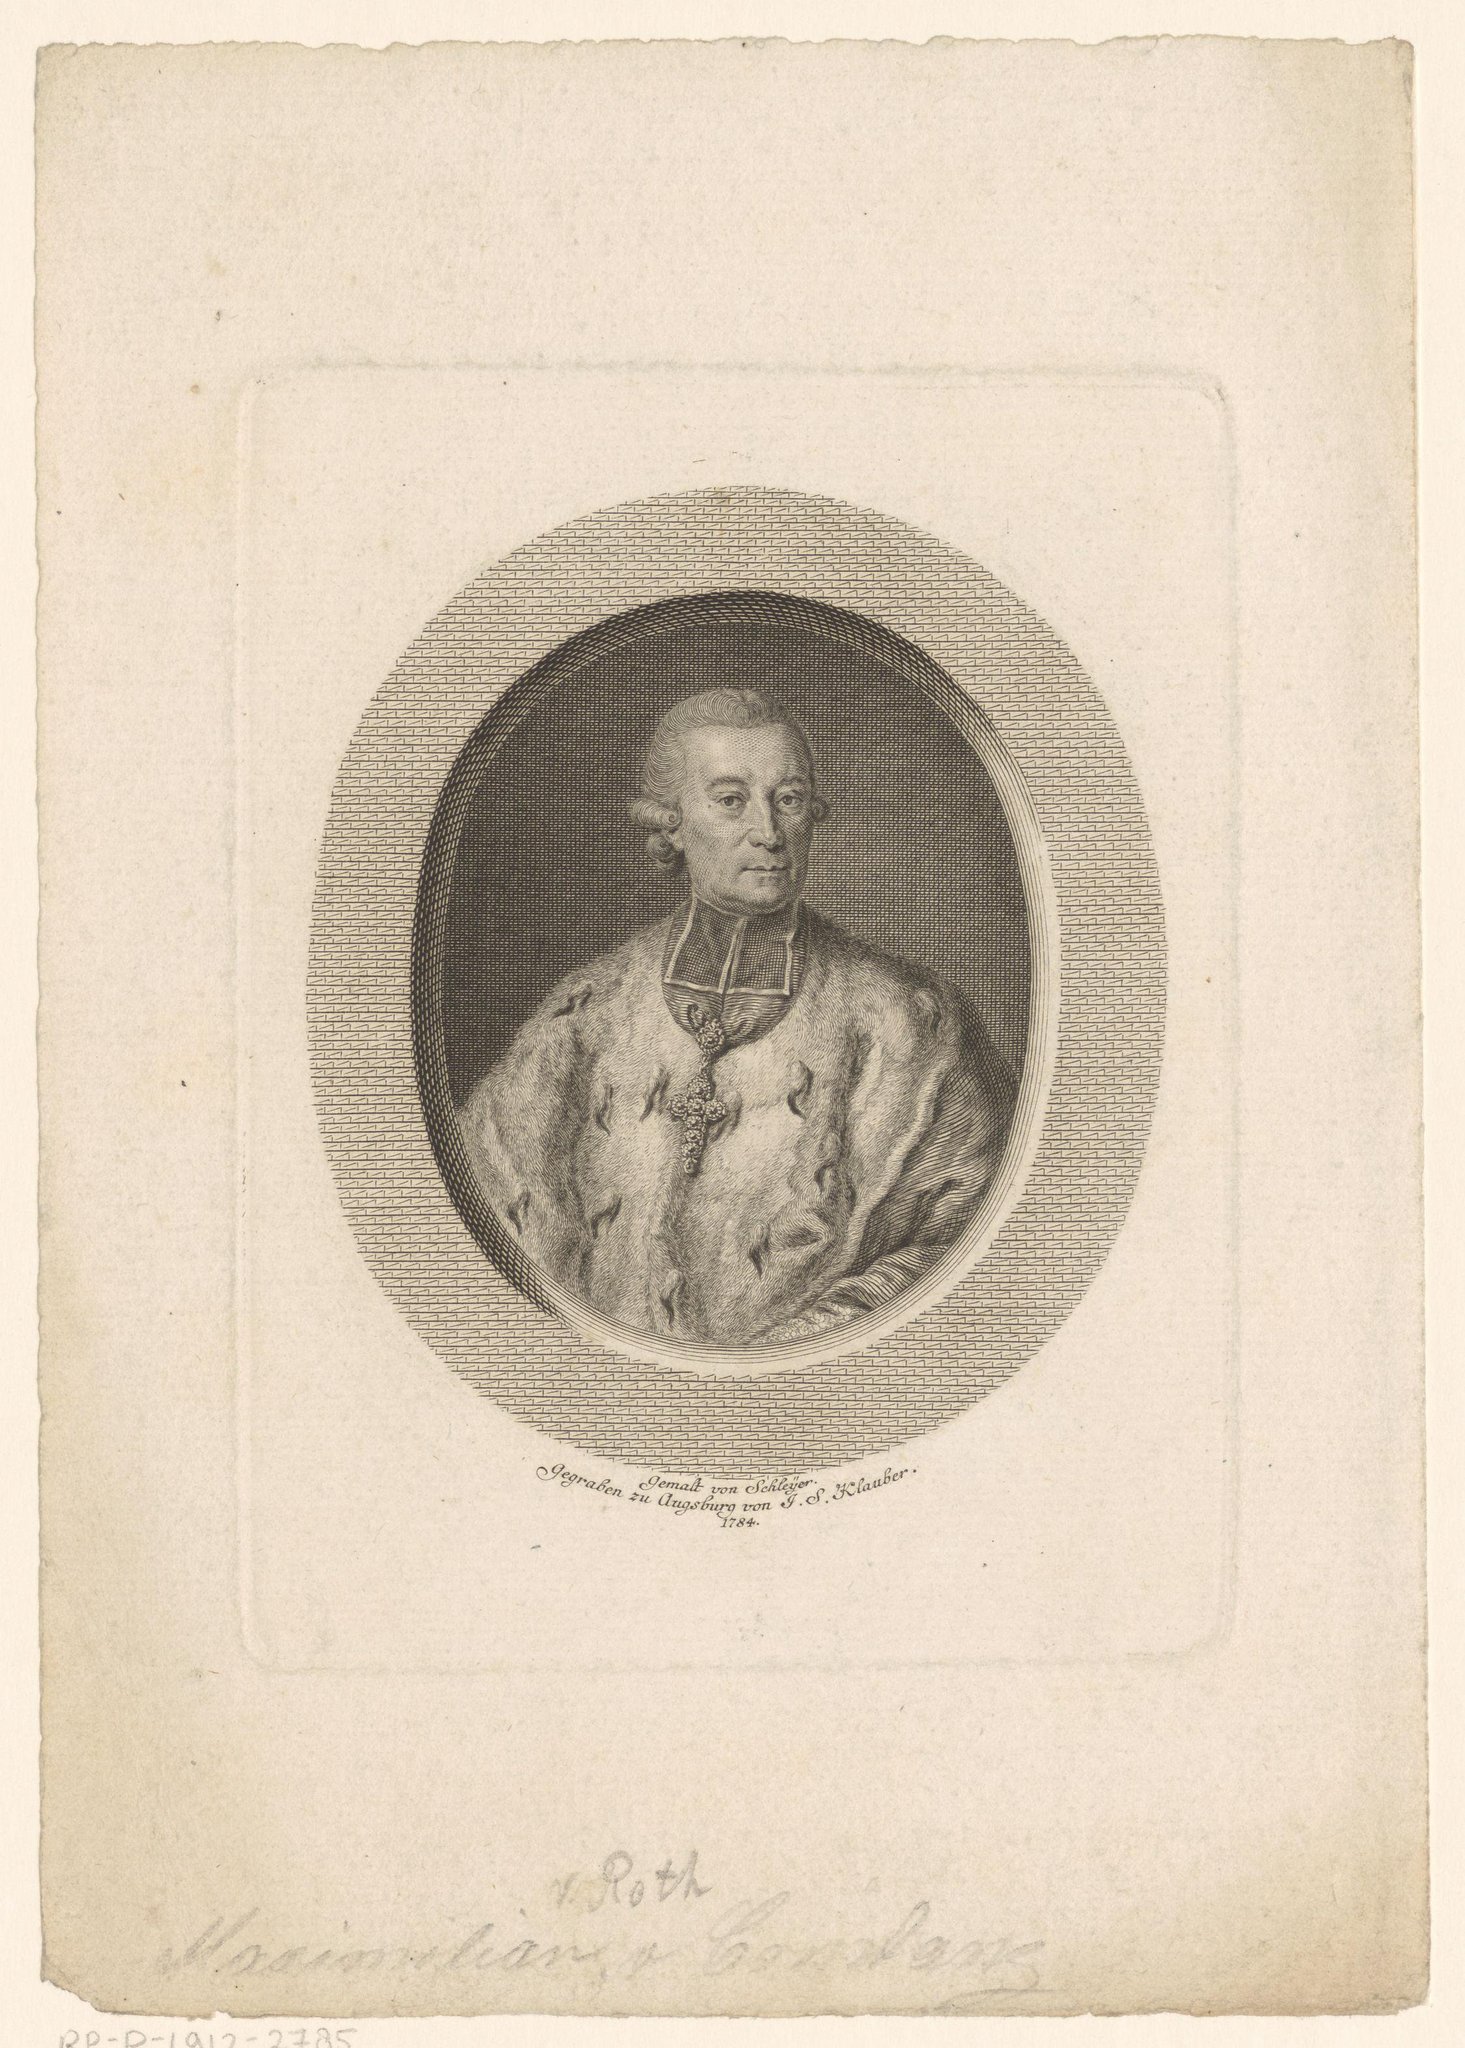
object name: print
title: Portret van Maximilian Christoph, bisschop van Konstanz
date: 1784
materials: paper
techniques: engraving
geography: augsburg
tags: archbishop, bishop, etc. (roman catholic), historical persons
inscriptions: collector's mark: Lugt 2228